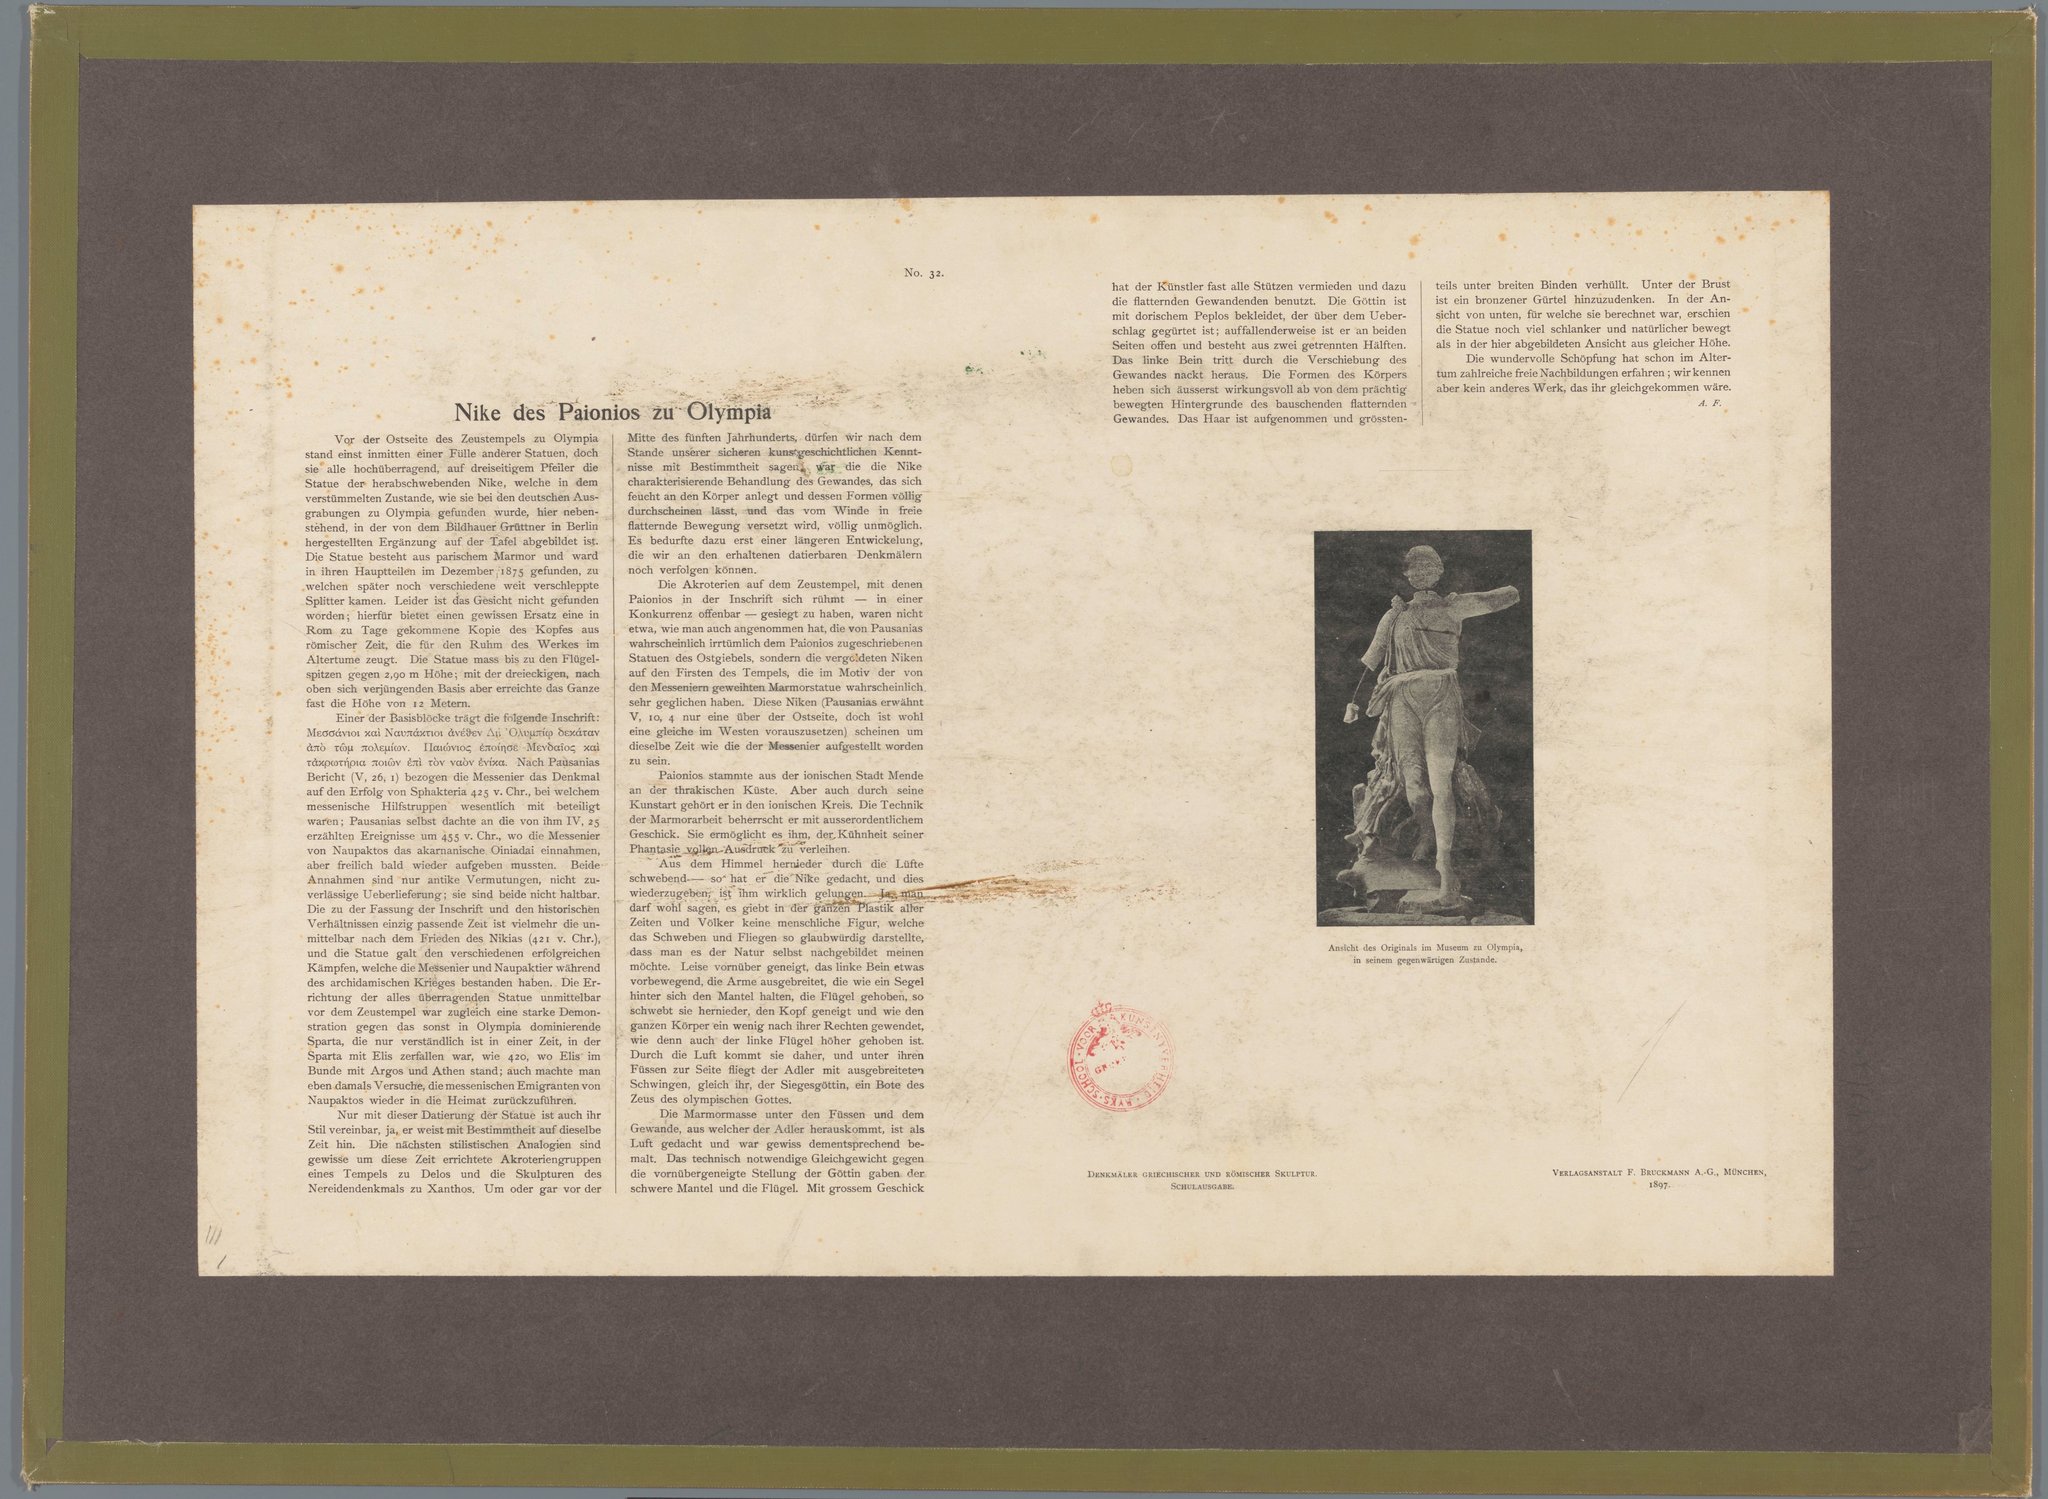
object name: photograph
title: Reconstructie van de Nikè van Paionios te Olympia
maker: Anonymous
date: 1896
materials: cardboard, paper, ink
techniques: photograph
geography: munich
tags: sculpture, (story of) nike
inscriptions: collector's mark: Lugt 3937, number: ‘No. 32.’, inscription: